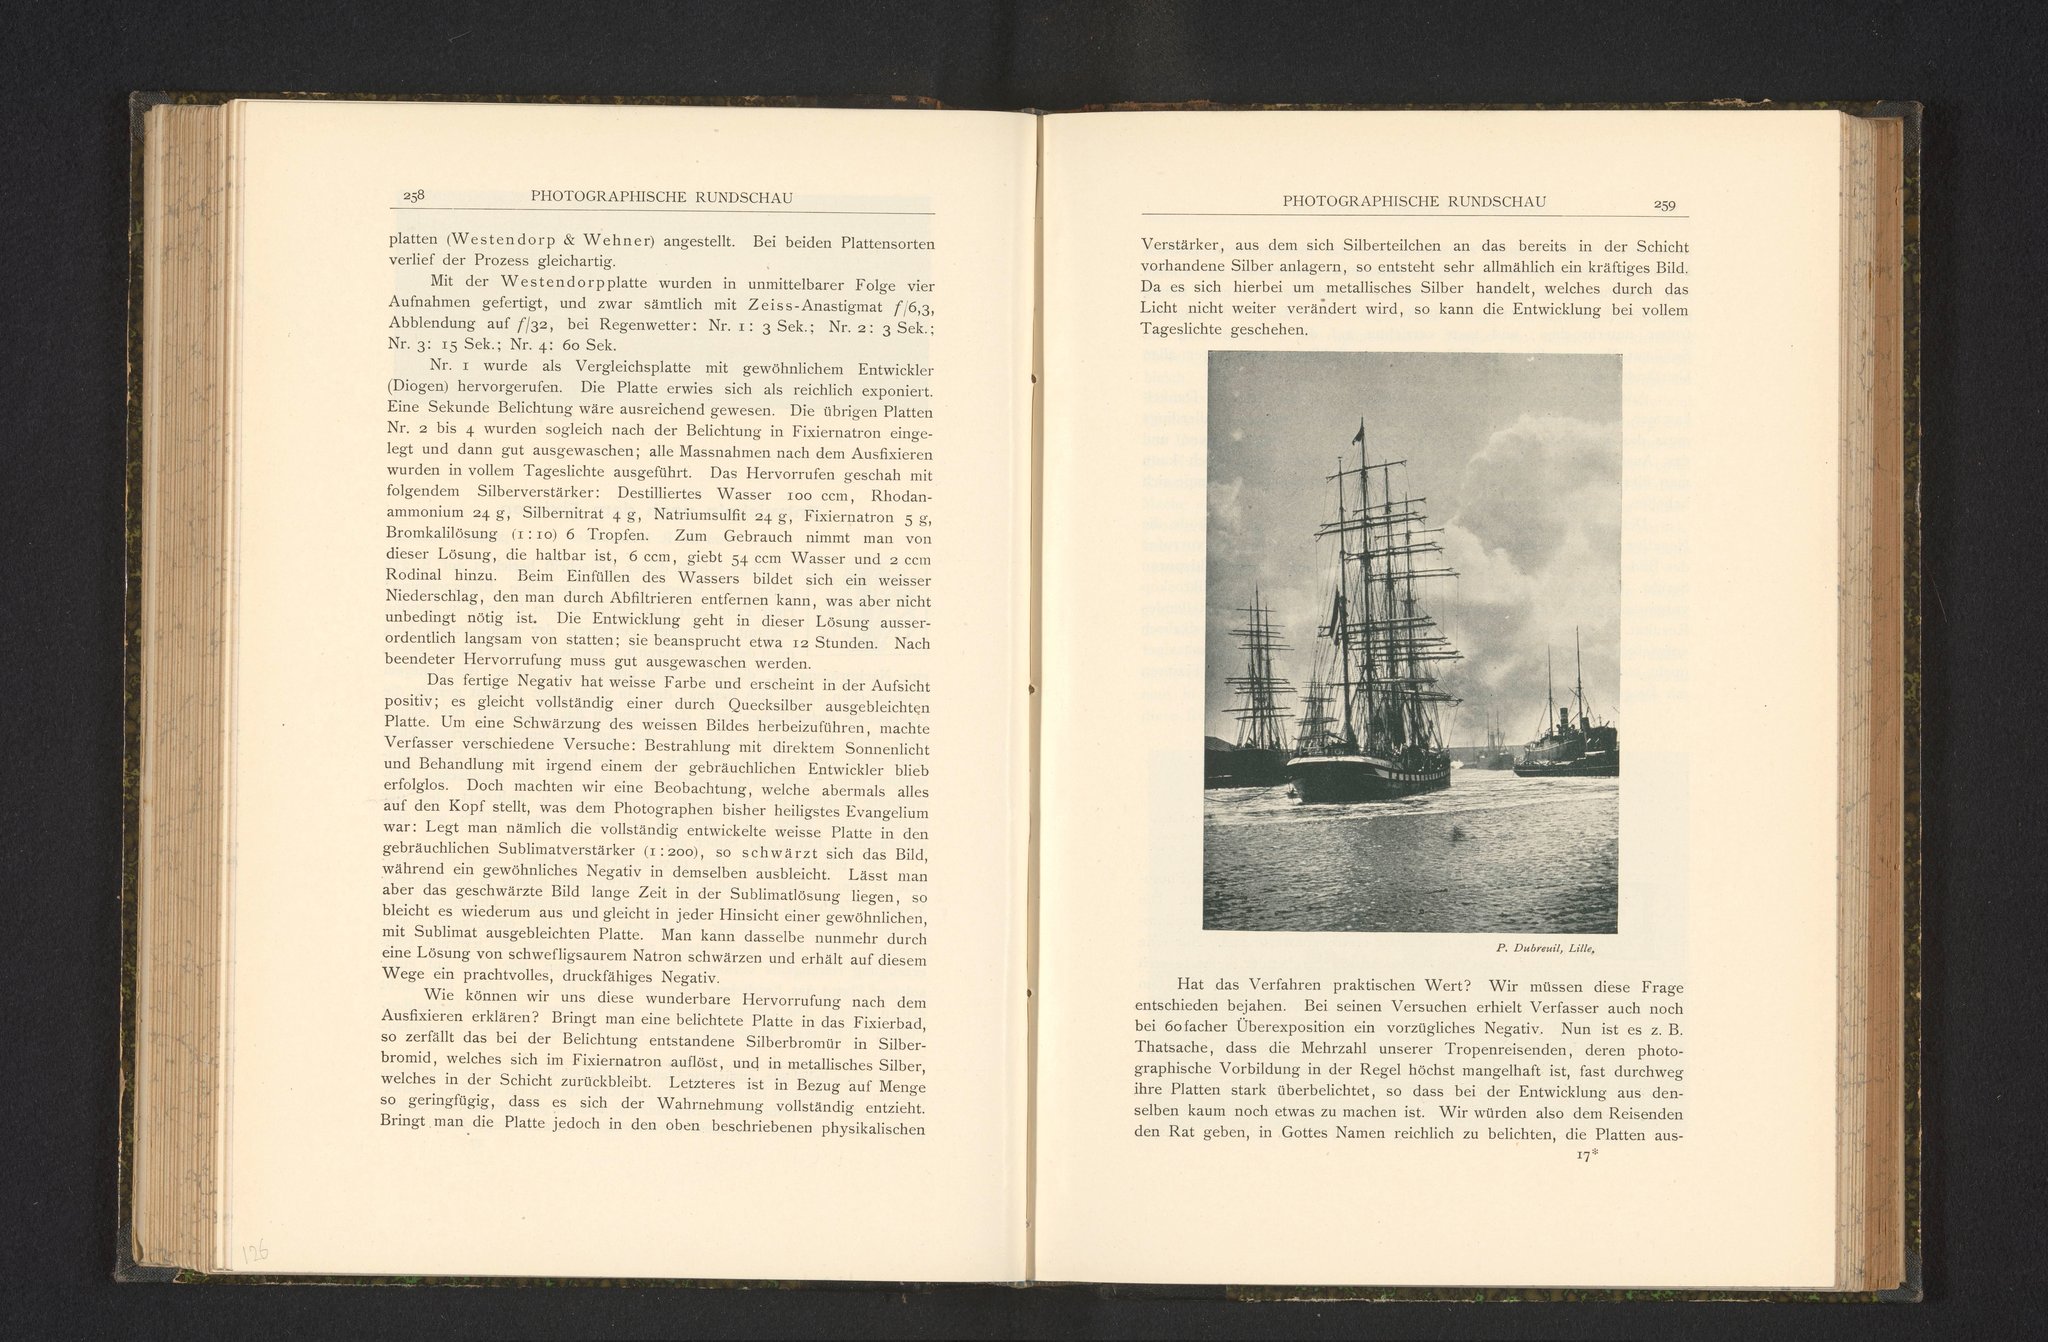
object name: page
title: Gezicht op een aantal zeilschepen te water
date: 1893-1898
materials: paper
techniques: autotype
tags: sailing-ship, sailing-boat, landscapes with waters, waterscapes, seascapes (in the temperate zone)